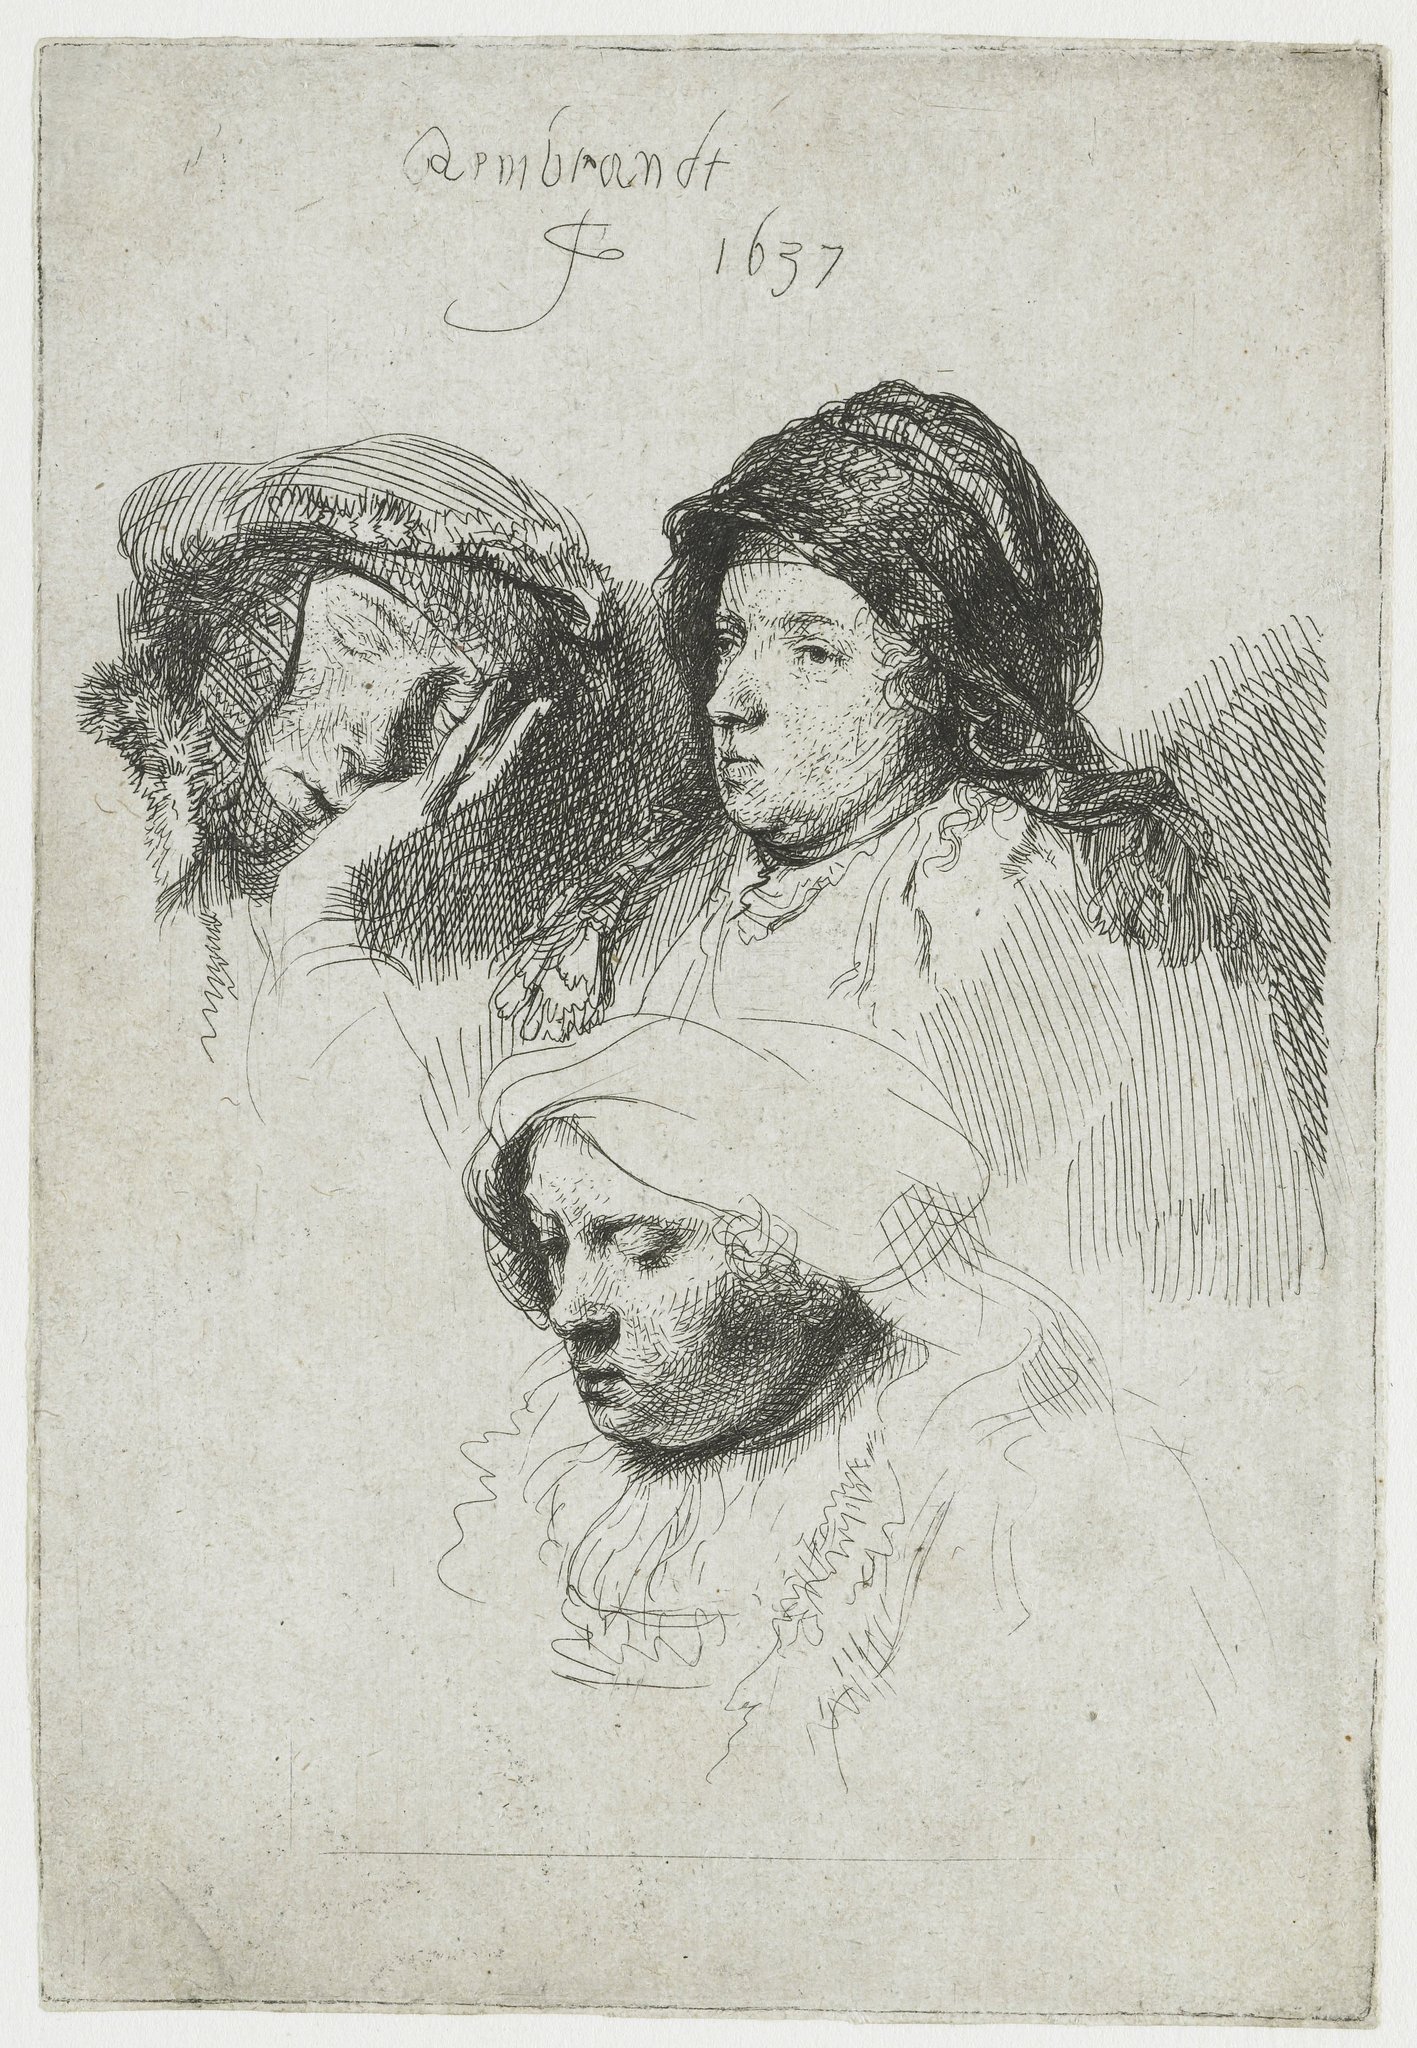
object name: print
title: Three Heads of Women, One Asleep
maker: rembrandt van rijn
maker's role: draughtsman, painter, print maker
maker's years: 1606-1669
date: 1637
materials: paper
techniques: etching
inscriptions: mark: Lugt 2228, signature and date: ‘Rembrandt f 1637’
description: In 1634 Rembrandt married Saskia Uylenburgh, the daughter of a mayor of Leeuwarden. Almost all of the heads in these studies are of her. Rembrandt evidently thoroughly enjoyed portraying his new bride in ever-different poses. The fluid lines suggest that he drew directly on the etching ground, at times without his models being aware of it.